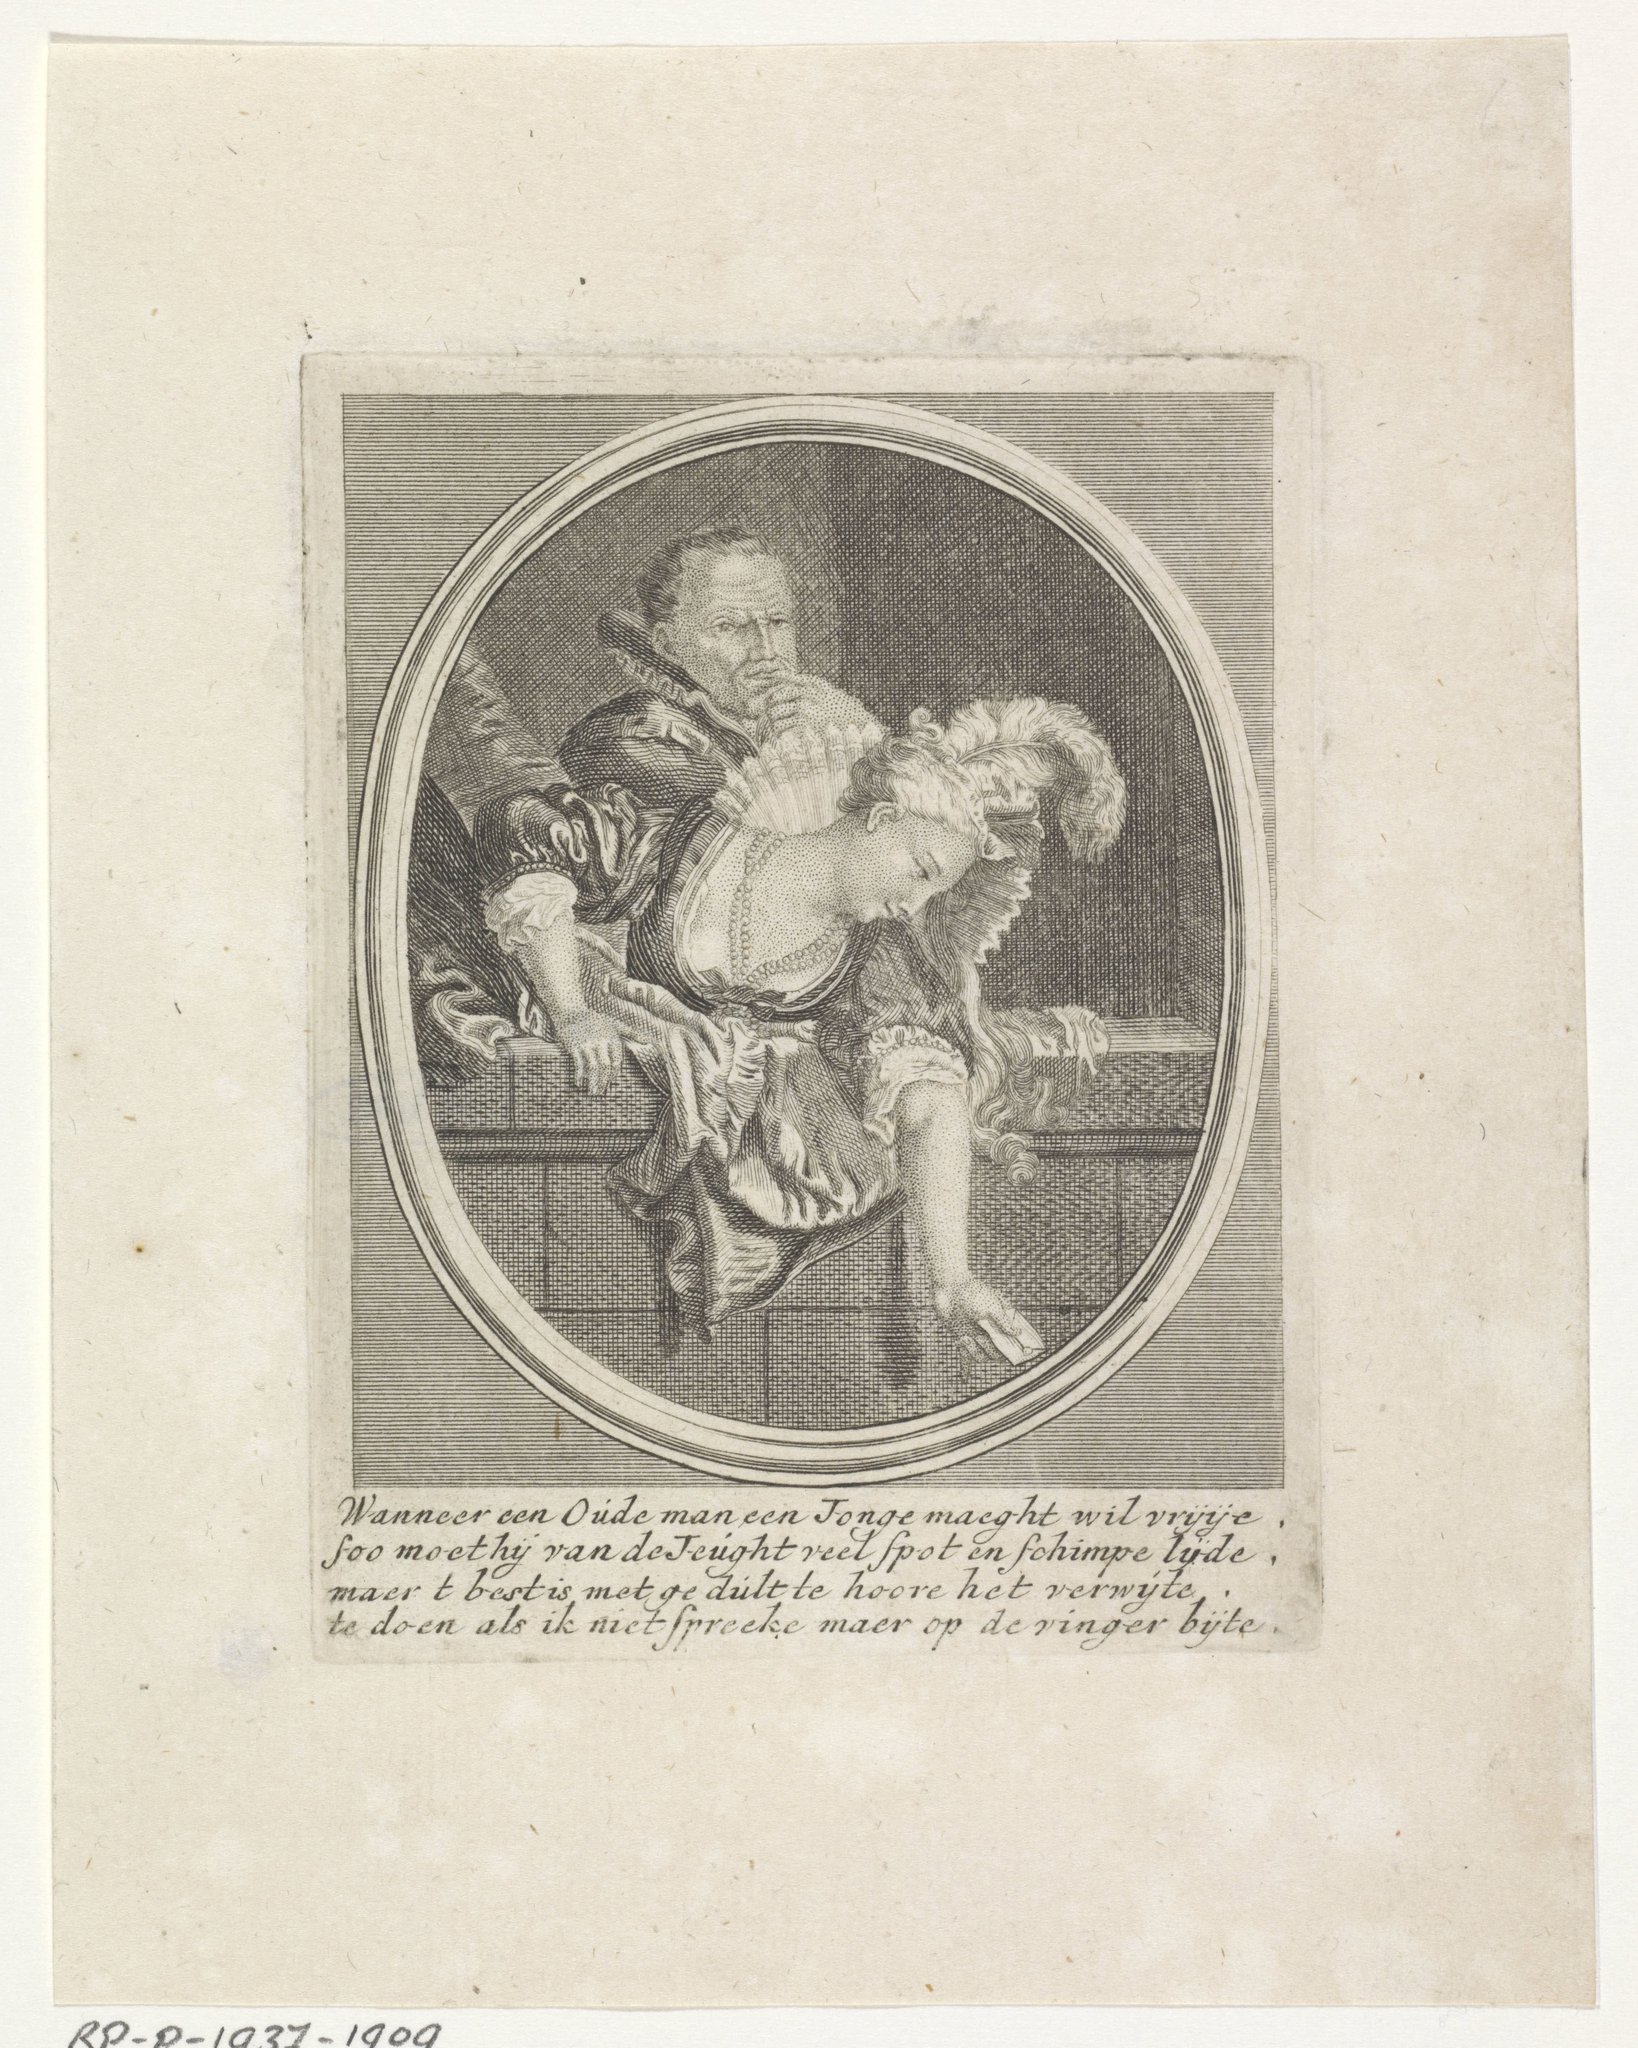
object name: print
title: Jonge vrouw en oude man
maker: Anonymous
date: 1700-1900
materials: paper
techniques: engraving, etching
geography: netherlands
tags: unequal couple, ill-matched couple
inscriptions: collector's mark: Lugt 2760, collector's mark: Lugt 2228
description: Een jonge maagd reikt over een muur met een envelop in de hand. Achter haar staat een oude man die op zijn vinger bijt. Onder de voorstelling een vierregelig vers in het Nederlands.